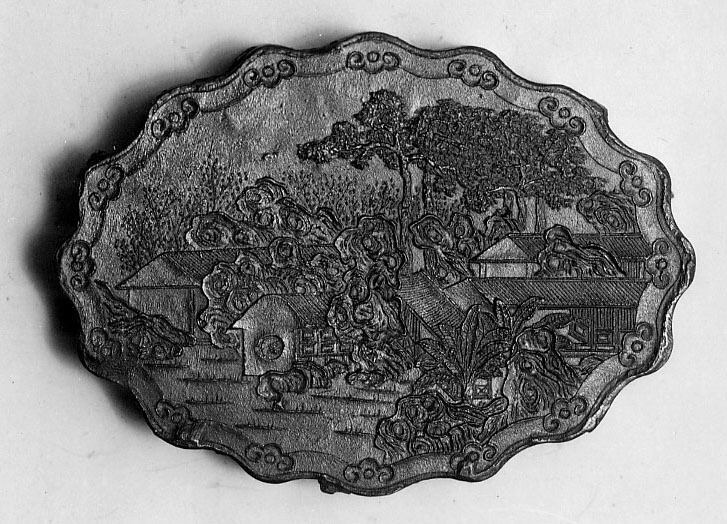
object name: ink tablet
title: The Secret Cove, or a Cove Lost in Sinuosities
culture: chinese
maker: jian guzhai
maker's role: artist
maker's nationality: chinese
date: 1867-1933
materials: ink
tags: houses